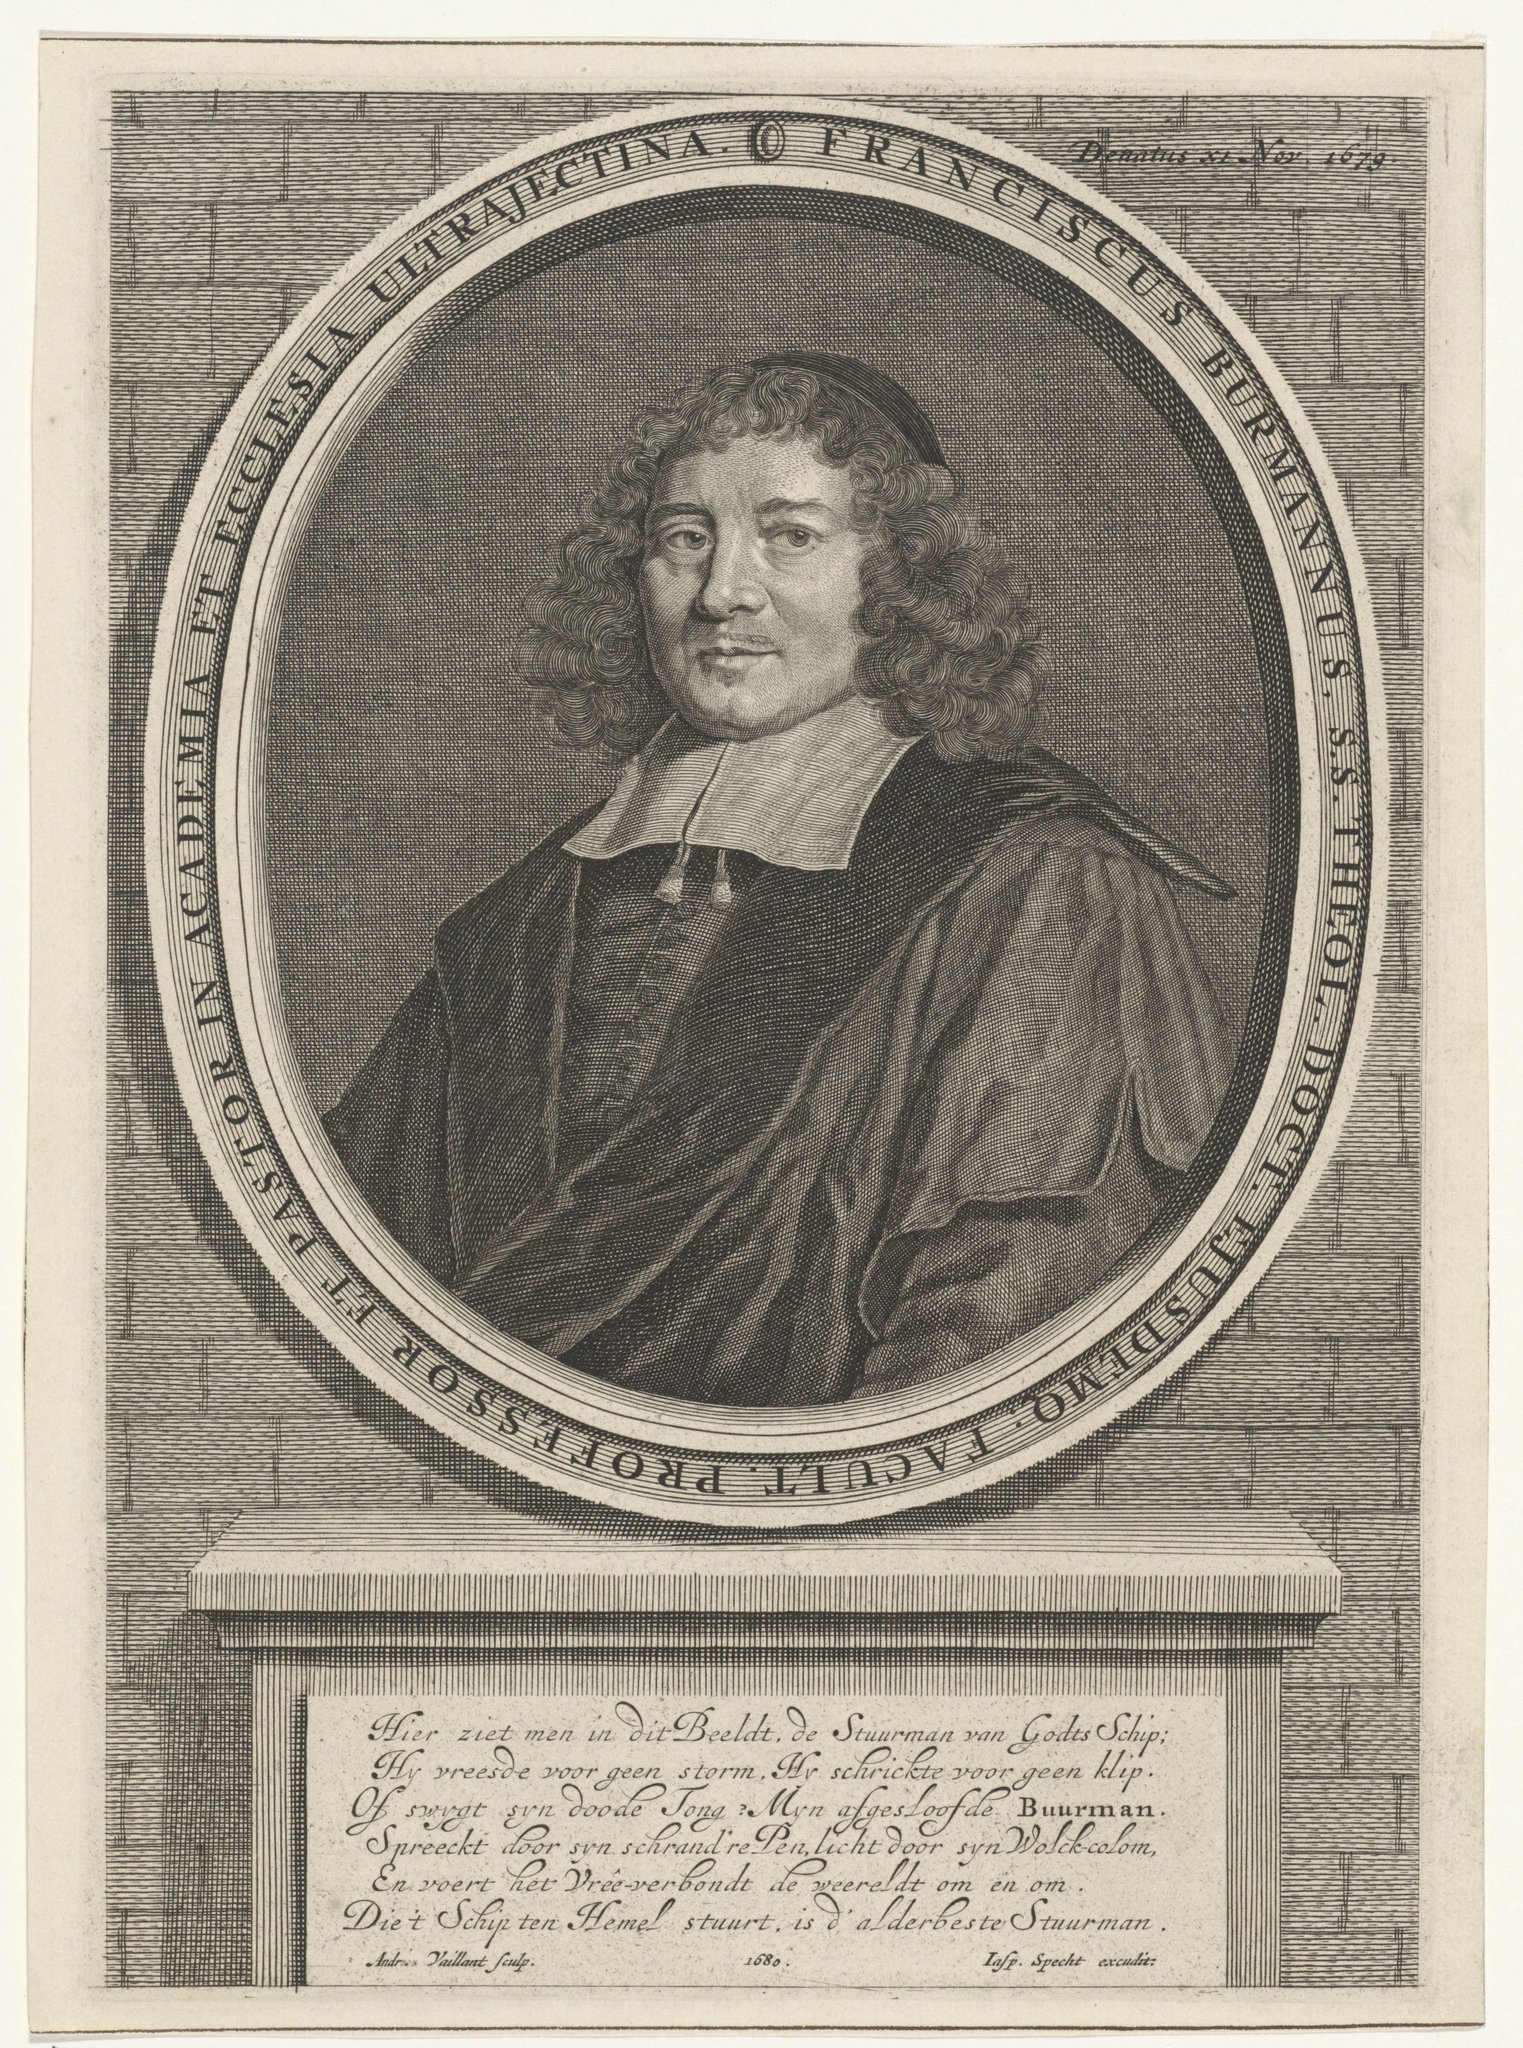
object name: print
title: Portret van Frans Burman (I)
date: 1680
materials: paper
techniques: engraving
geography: utrecht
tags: leiden, utrecht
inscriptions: collector's mark: Lugt 240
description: Portret van de theoloog en hoogleraar te Utrecht Frans Burman (I)